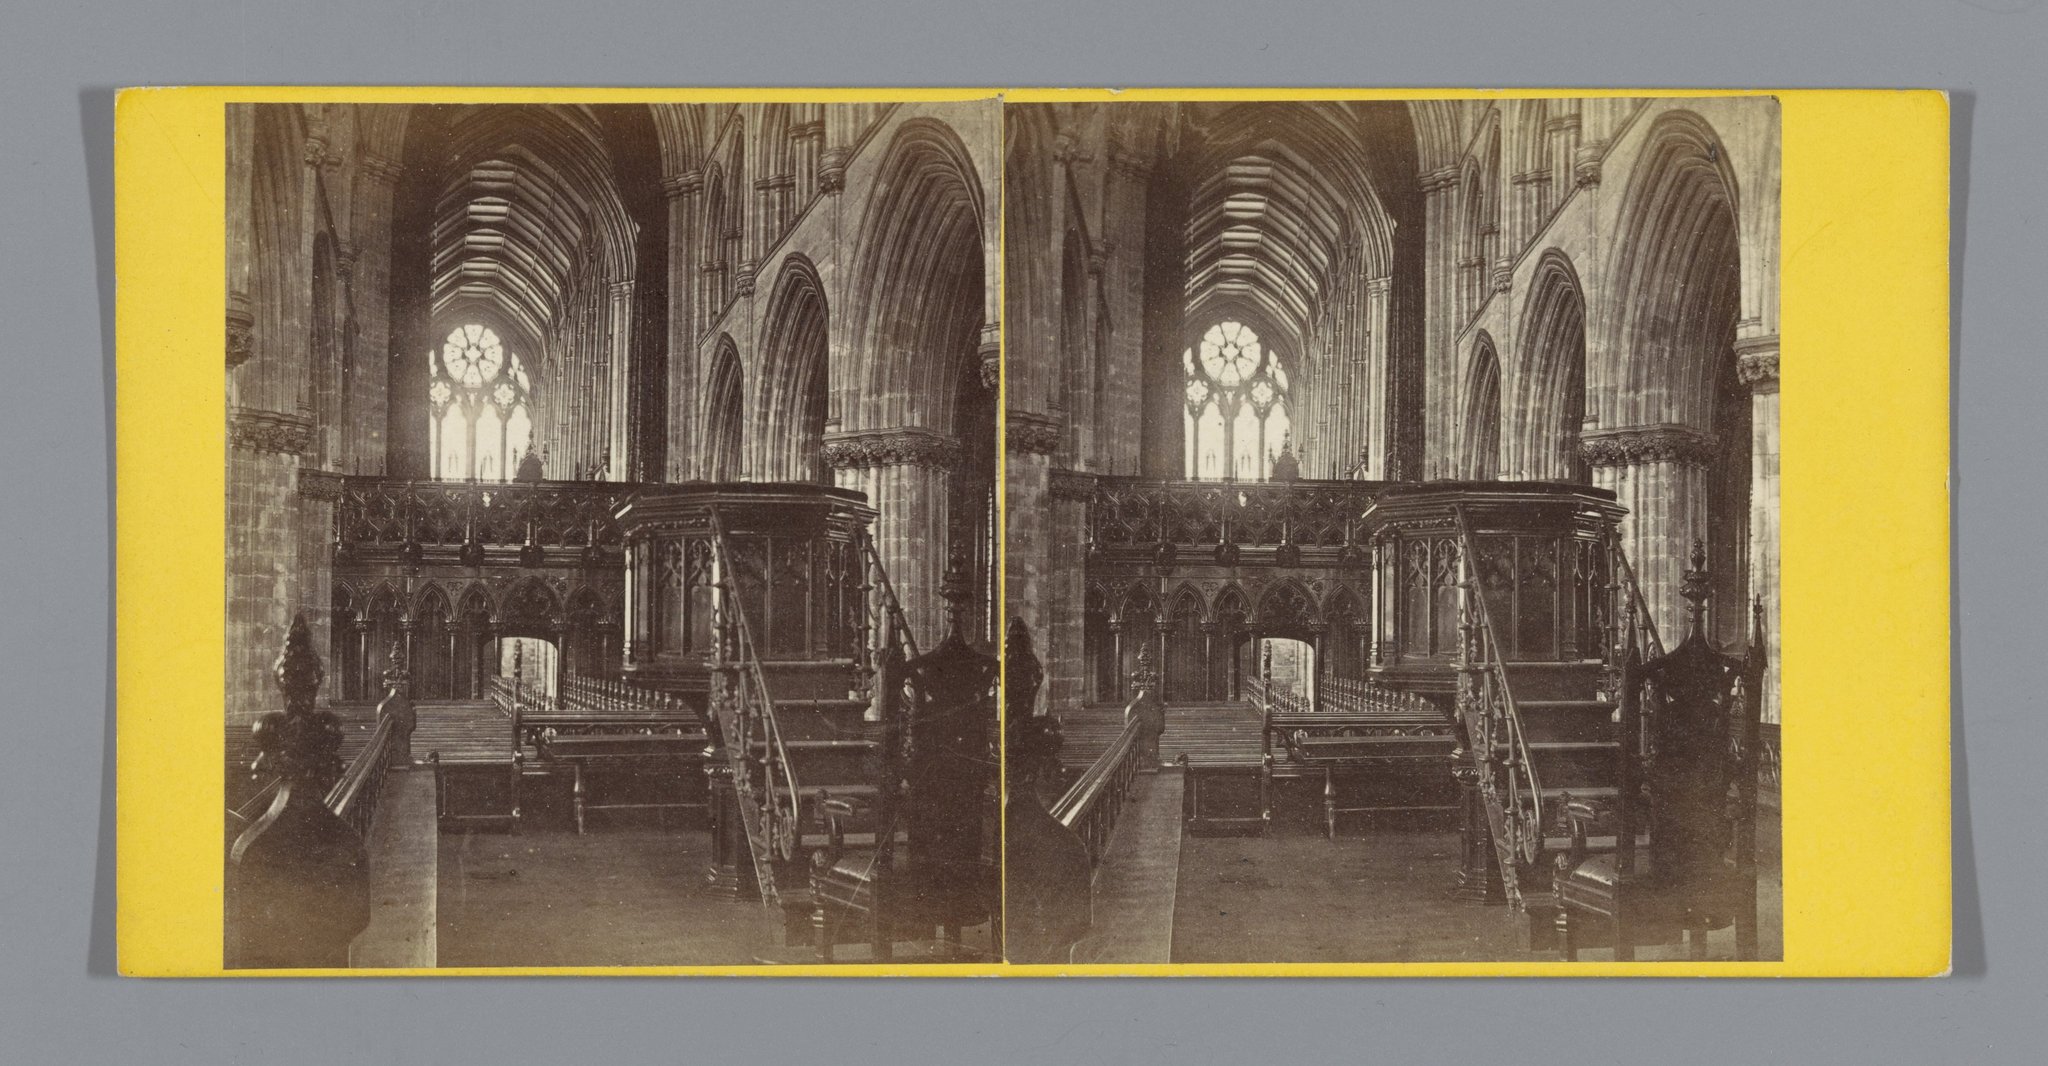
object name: stereograph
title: Glasgow Cathedral.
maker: archibald burns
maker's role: fotograaf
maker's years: 1831-1880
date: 1850-1880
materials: cardboard, photographic support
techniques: albumen print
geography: glasgow cathedral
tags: interior of church, pulpit, ambo, chancel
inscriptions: inscription: ‘Views of Edinburgh and its Neighbourhood, &c.’